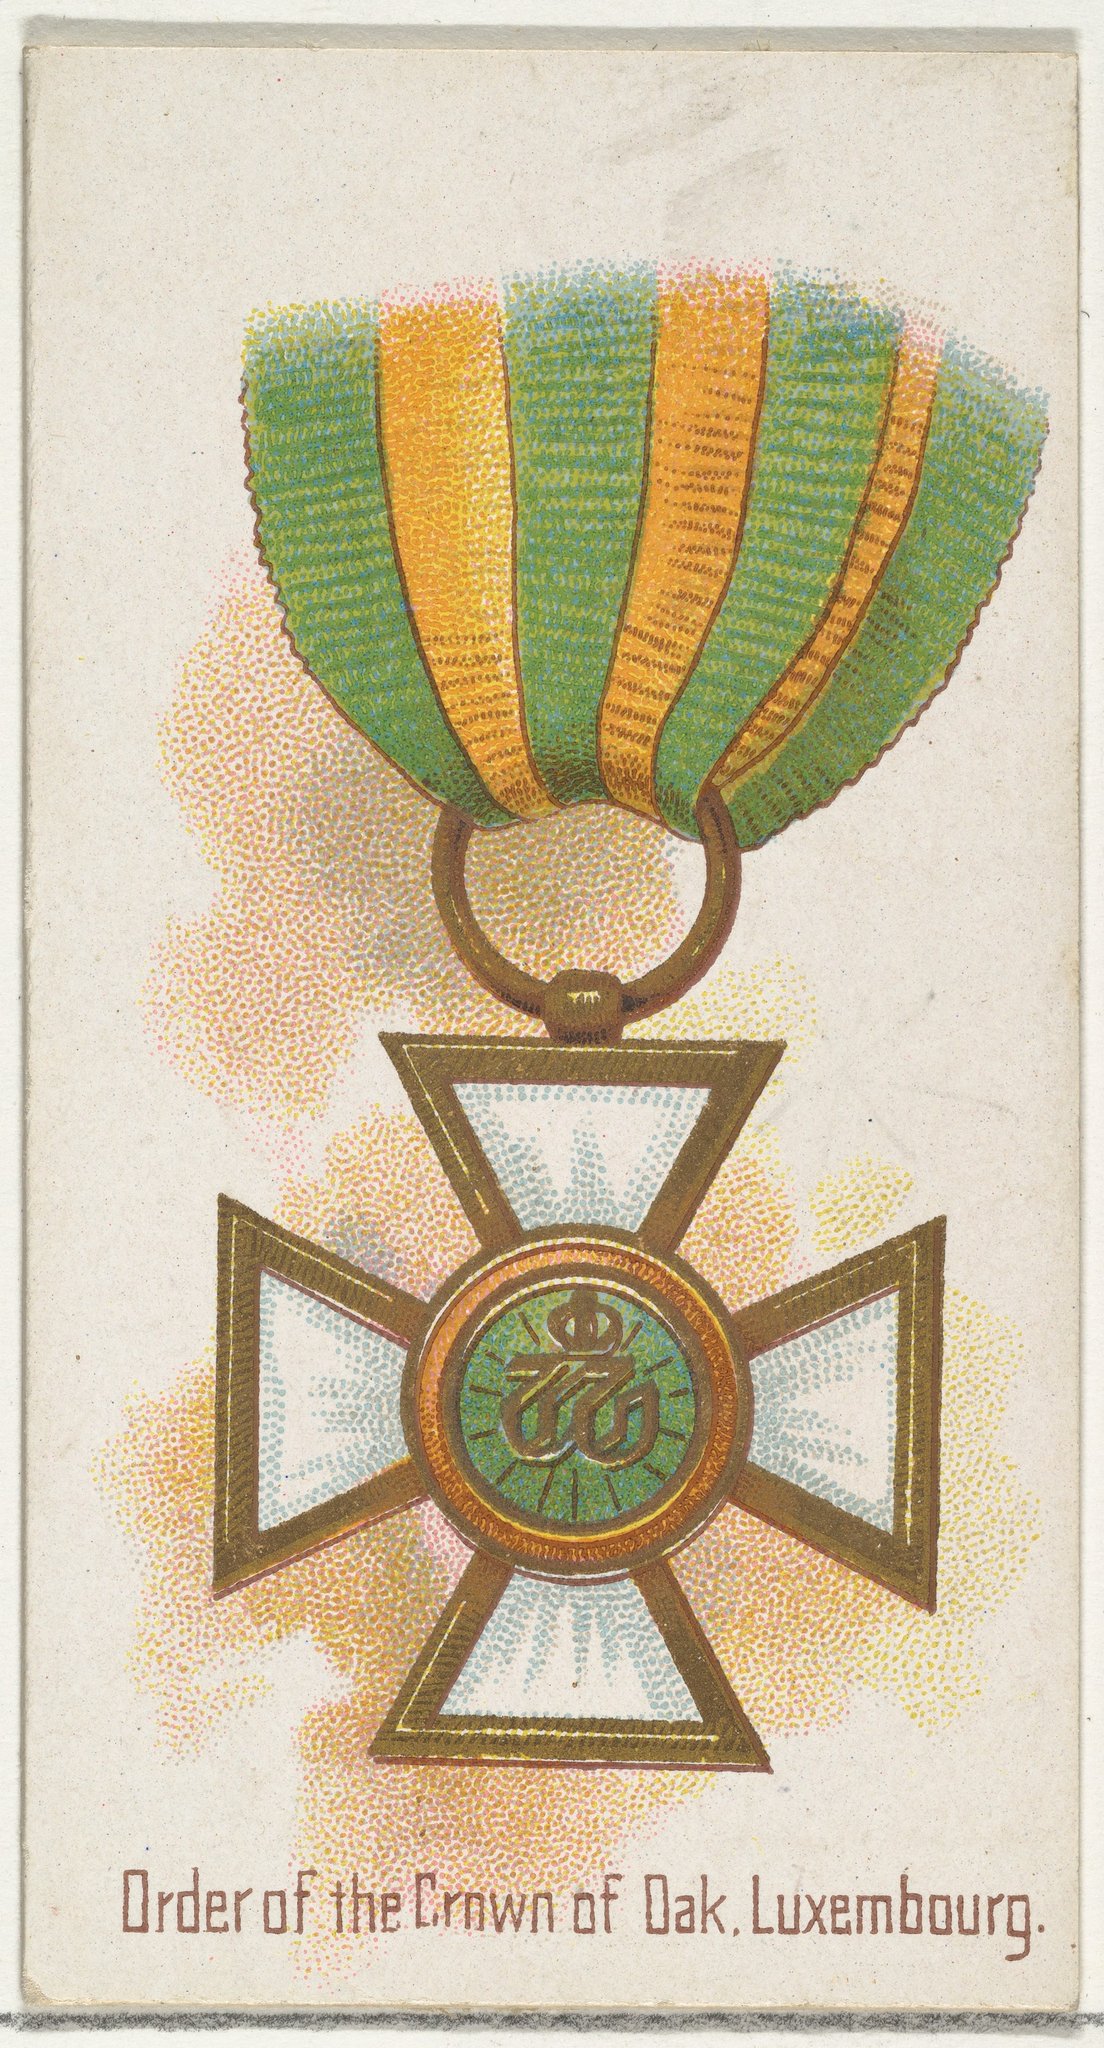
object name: print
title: Order of the Crown of Oak, Luxembourg, from the World's Decorations series (N30) for Allen & Ginter Cigarettes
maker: allen & ginter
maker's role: publisher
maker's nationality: american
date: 1890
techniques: color lithograph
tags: medals